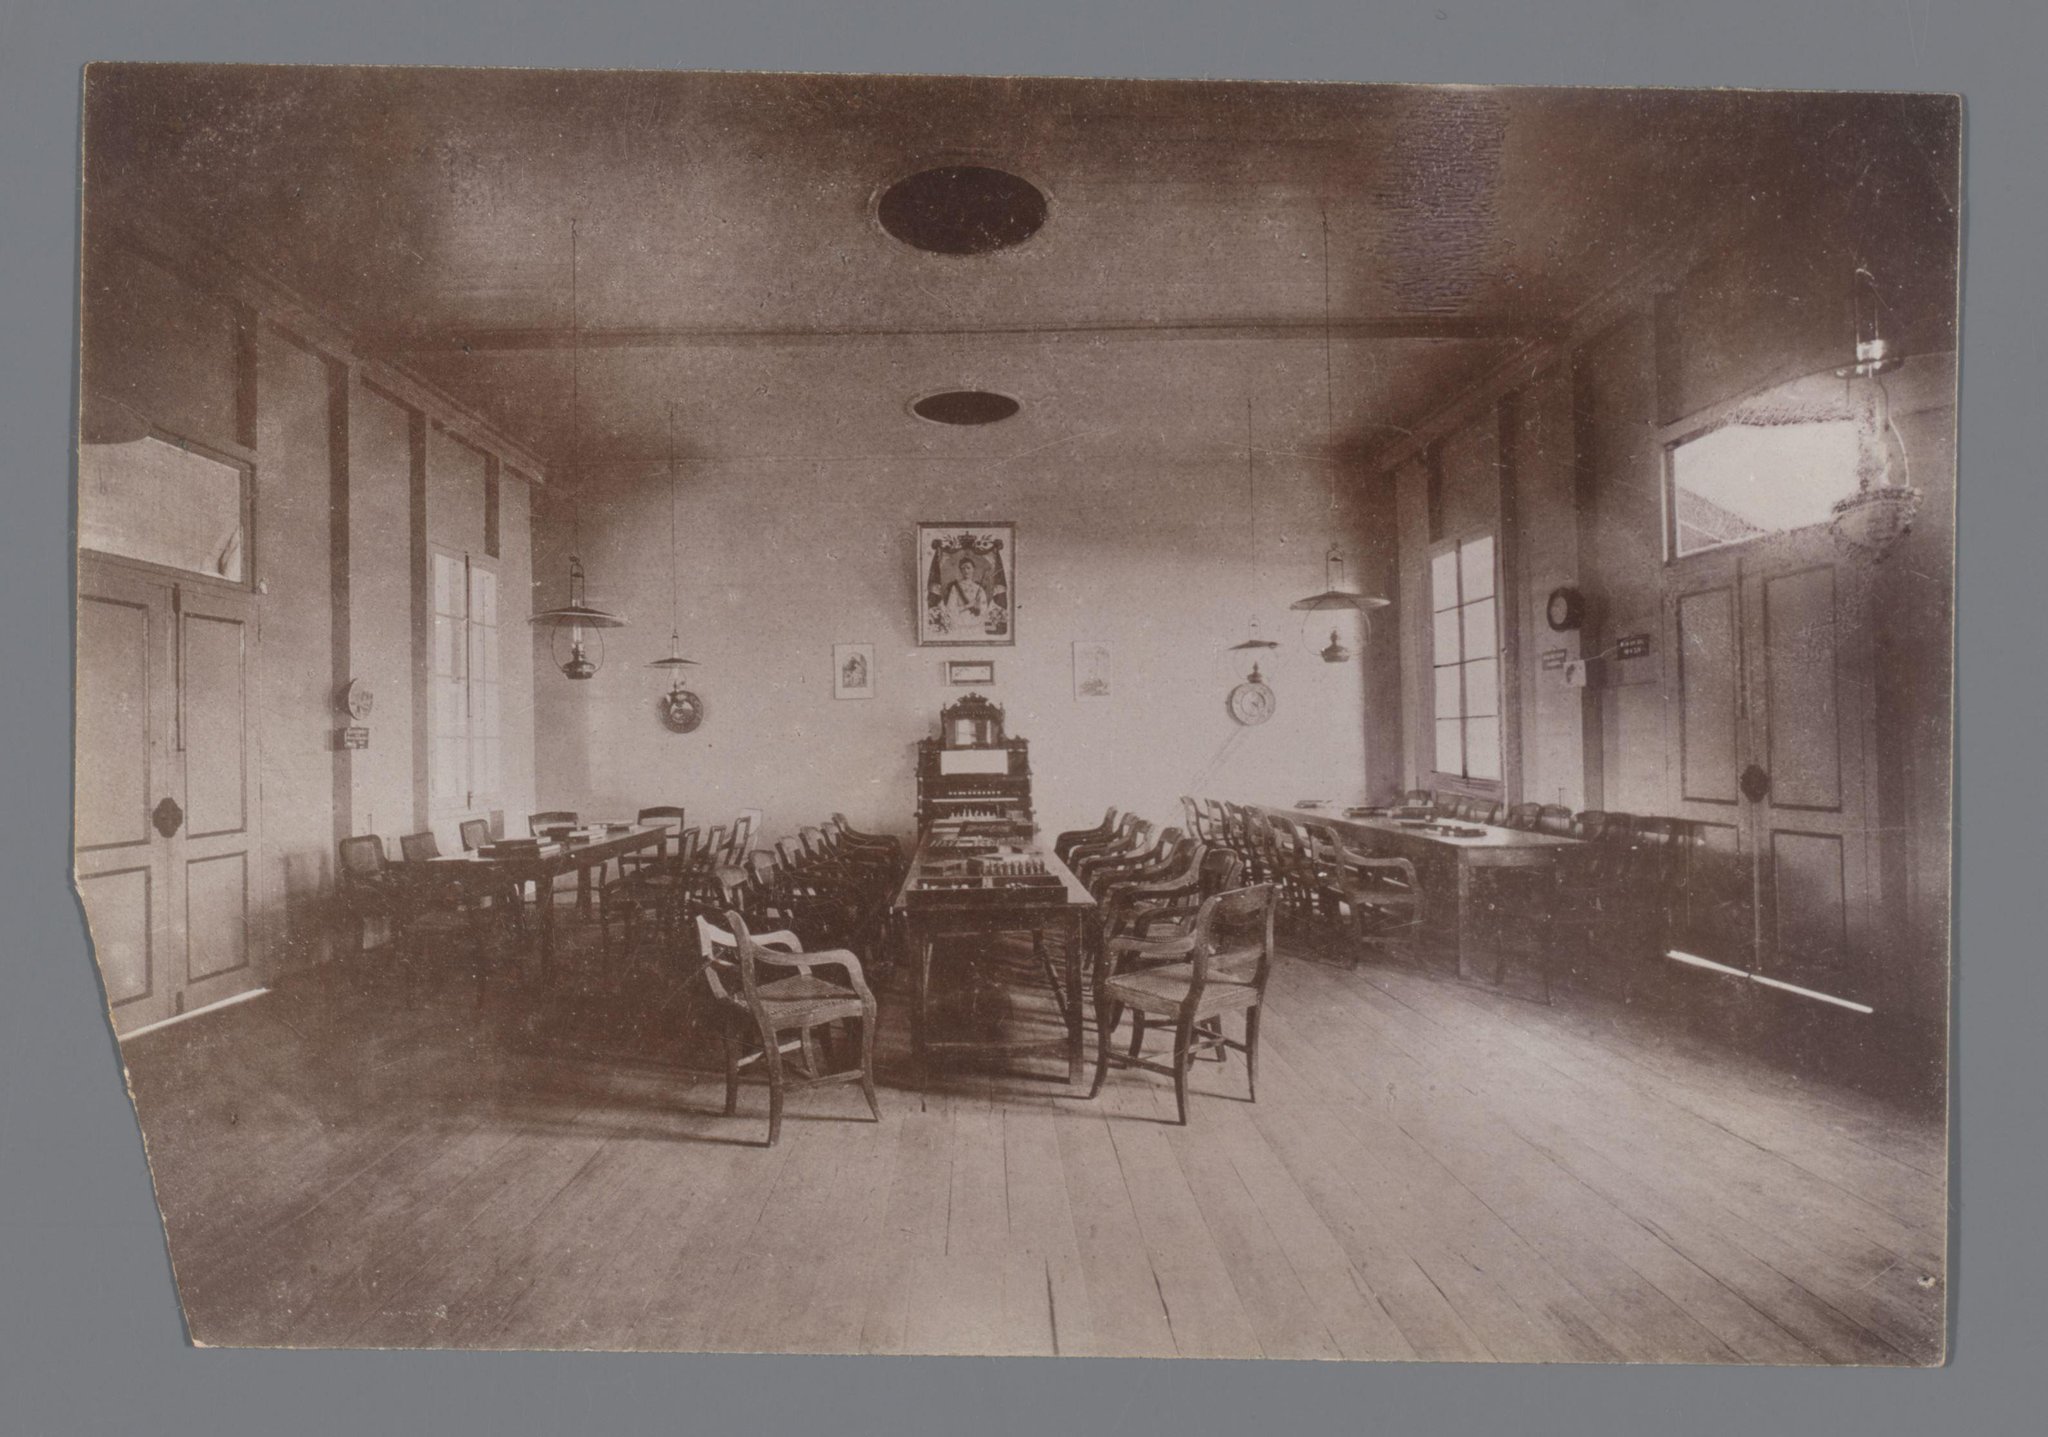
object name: photograph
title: Interieur van het Militair Tehuis Koningin Wilhelmina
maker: Anonymous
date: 1900-1940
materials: photographic support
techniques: collodion silver print, gelatin silver print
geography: sumatra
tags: sumatra, dutch east indies, the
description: Interieur van de recreatiezaal van het Militair Tehuis Koningin Wilhelmina, stoelen en tafels met boeken en bordspellen. Onderdeel van een groep van 14 losse foto's genomen op Midden- en Zuid-Sumatra in de periode ca. 1900-1940.